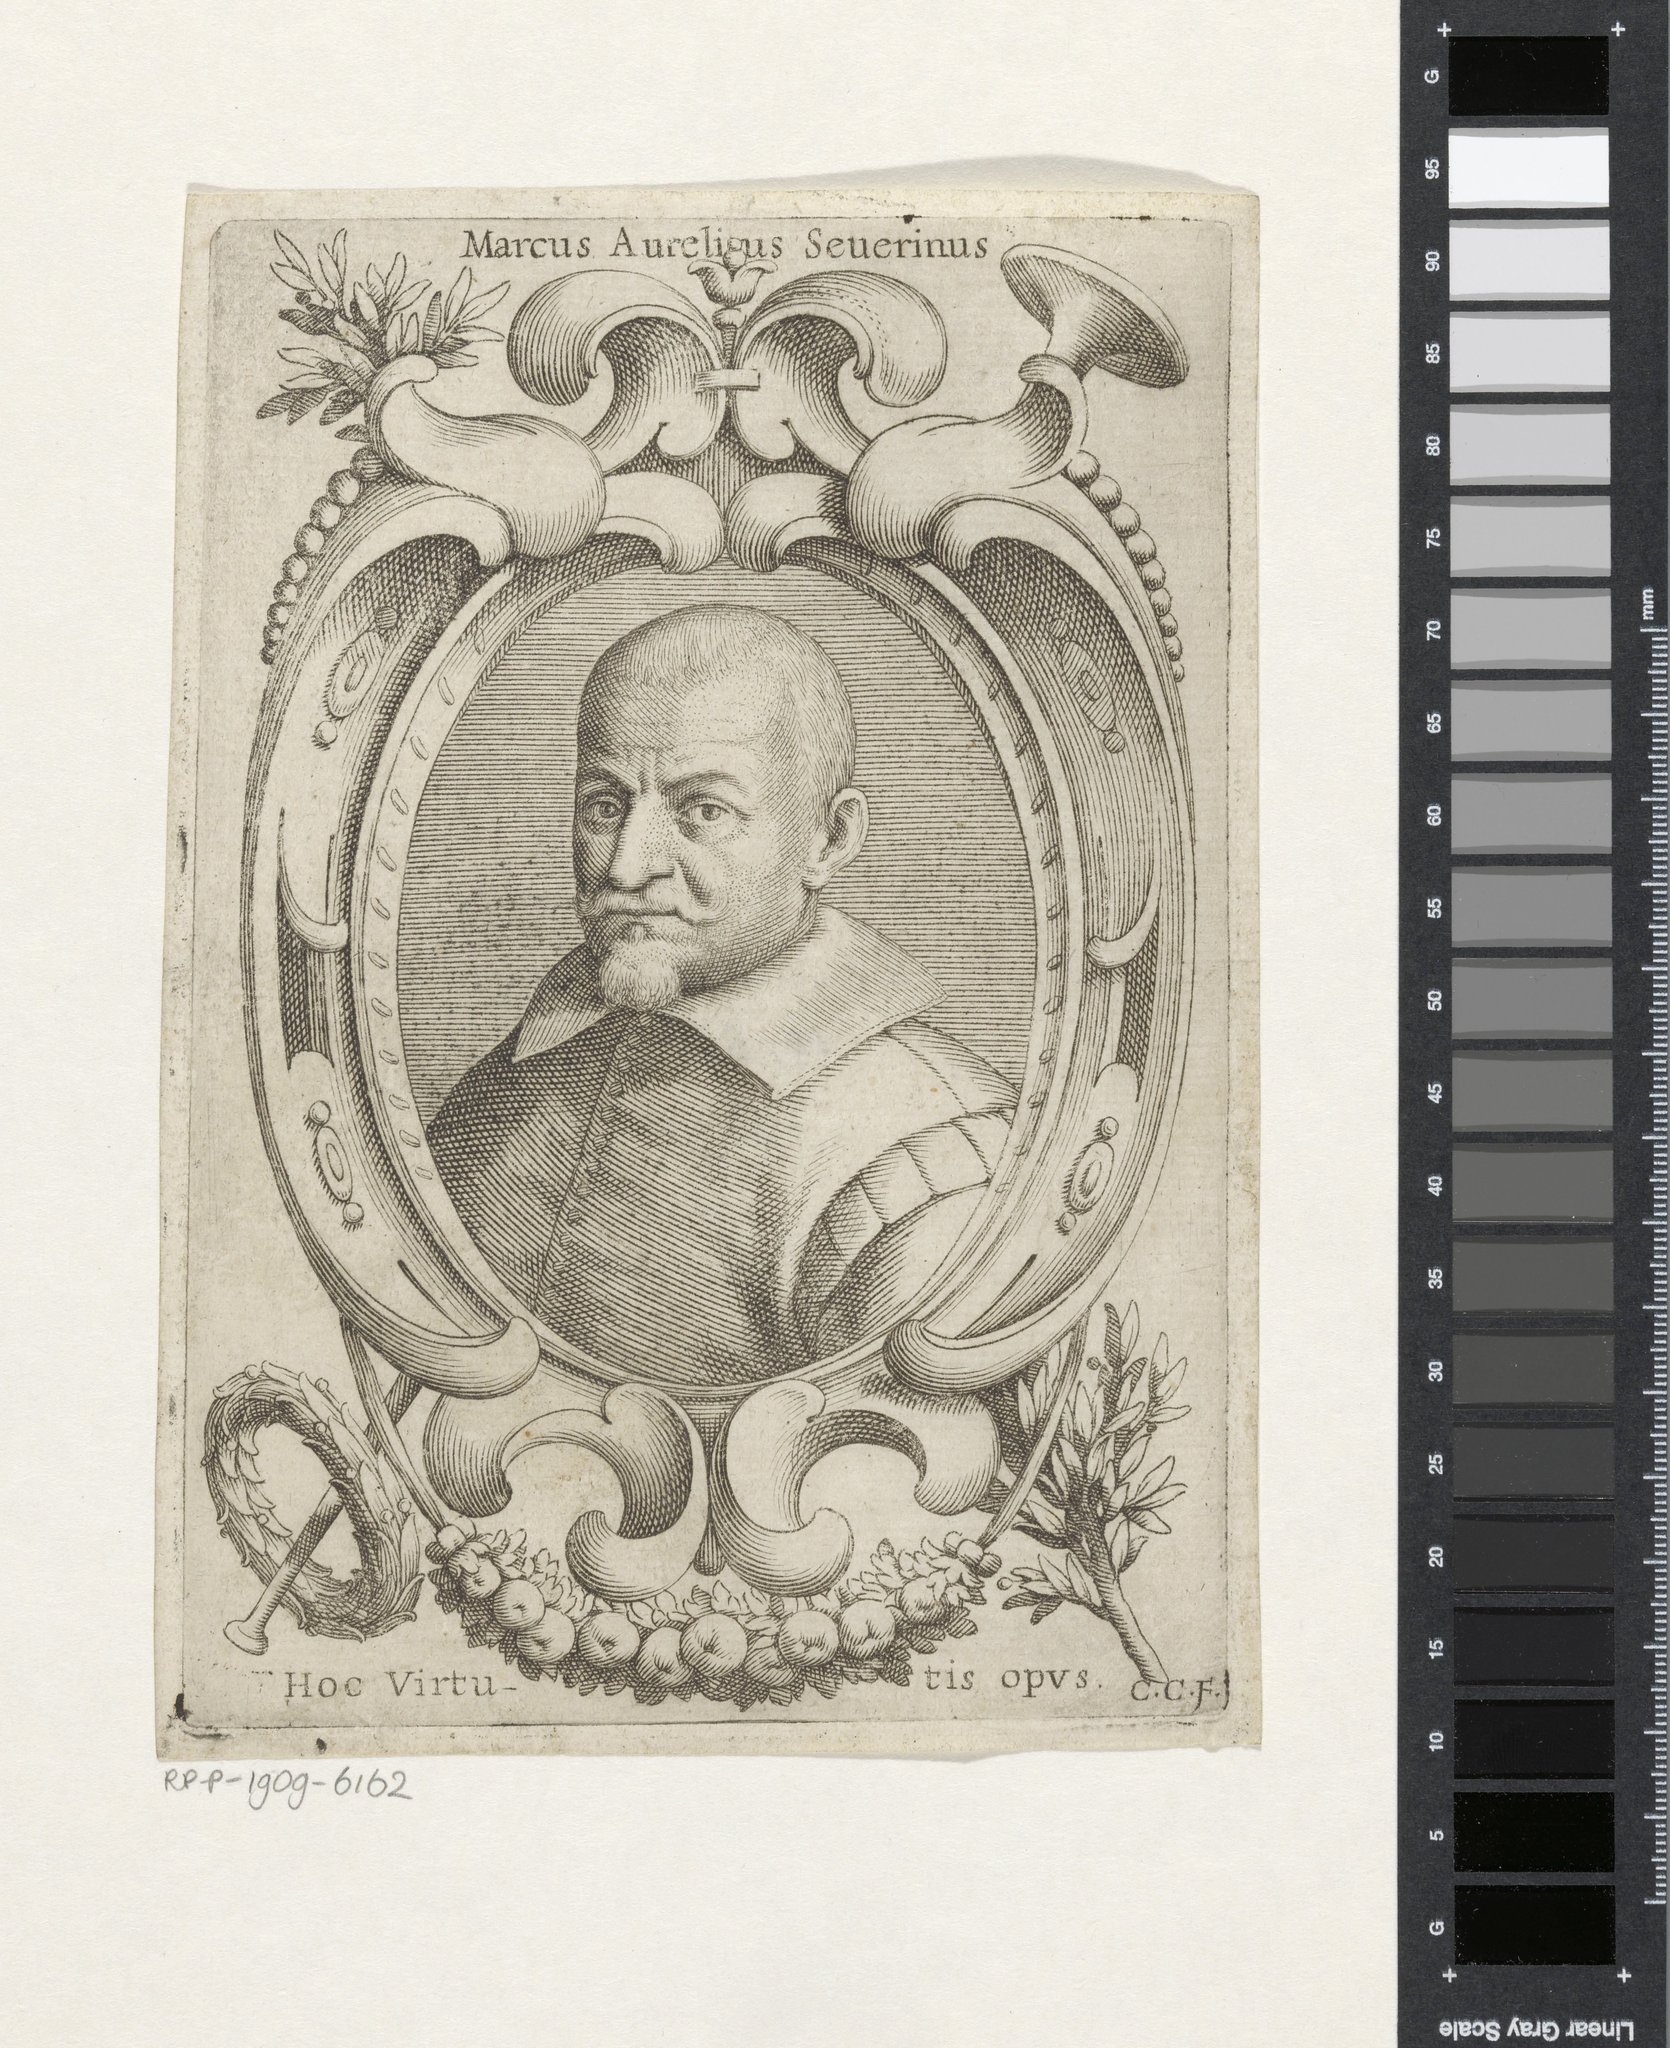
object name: print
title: Portret van chirurg Marco Aurelio Severino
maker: camillo cungi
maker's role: print maker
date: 1597-1649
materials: paper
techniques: engraving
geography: italy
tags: cosenza, naples, historical persons, barber; surgeon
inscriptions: collector's mark: Lugt 2228